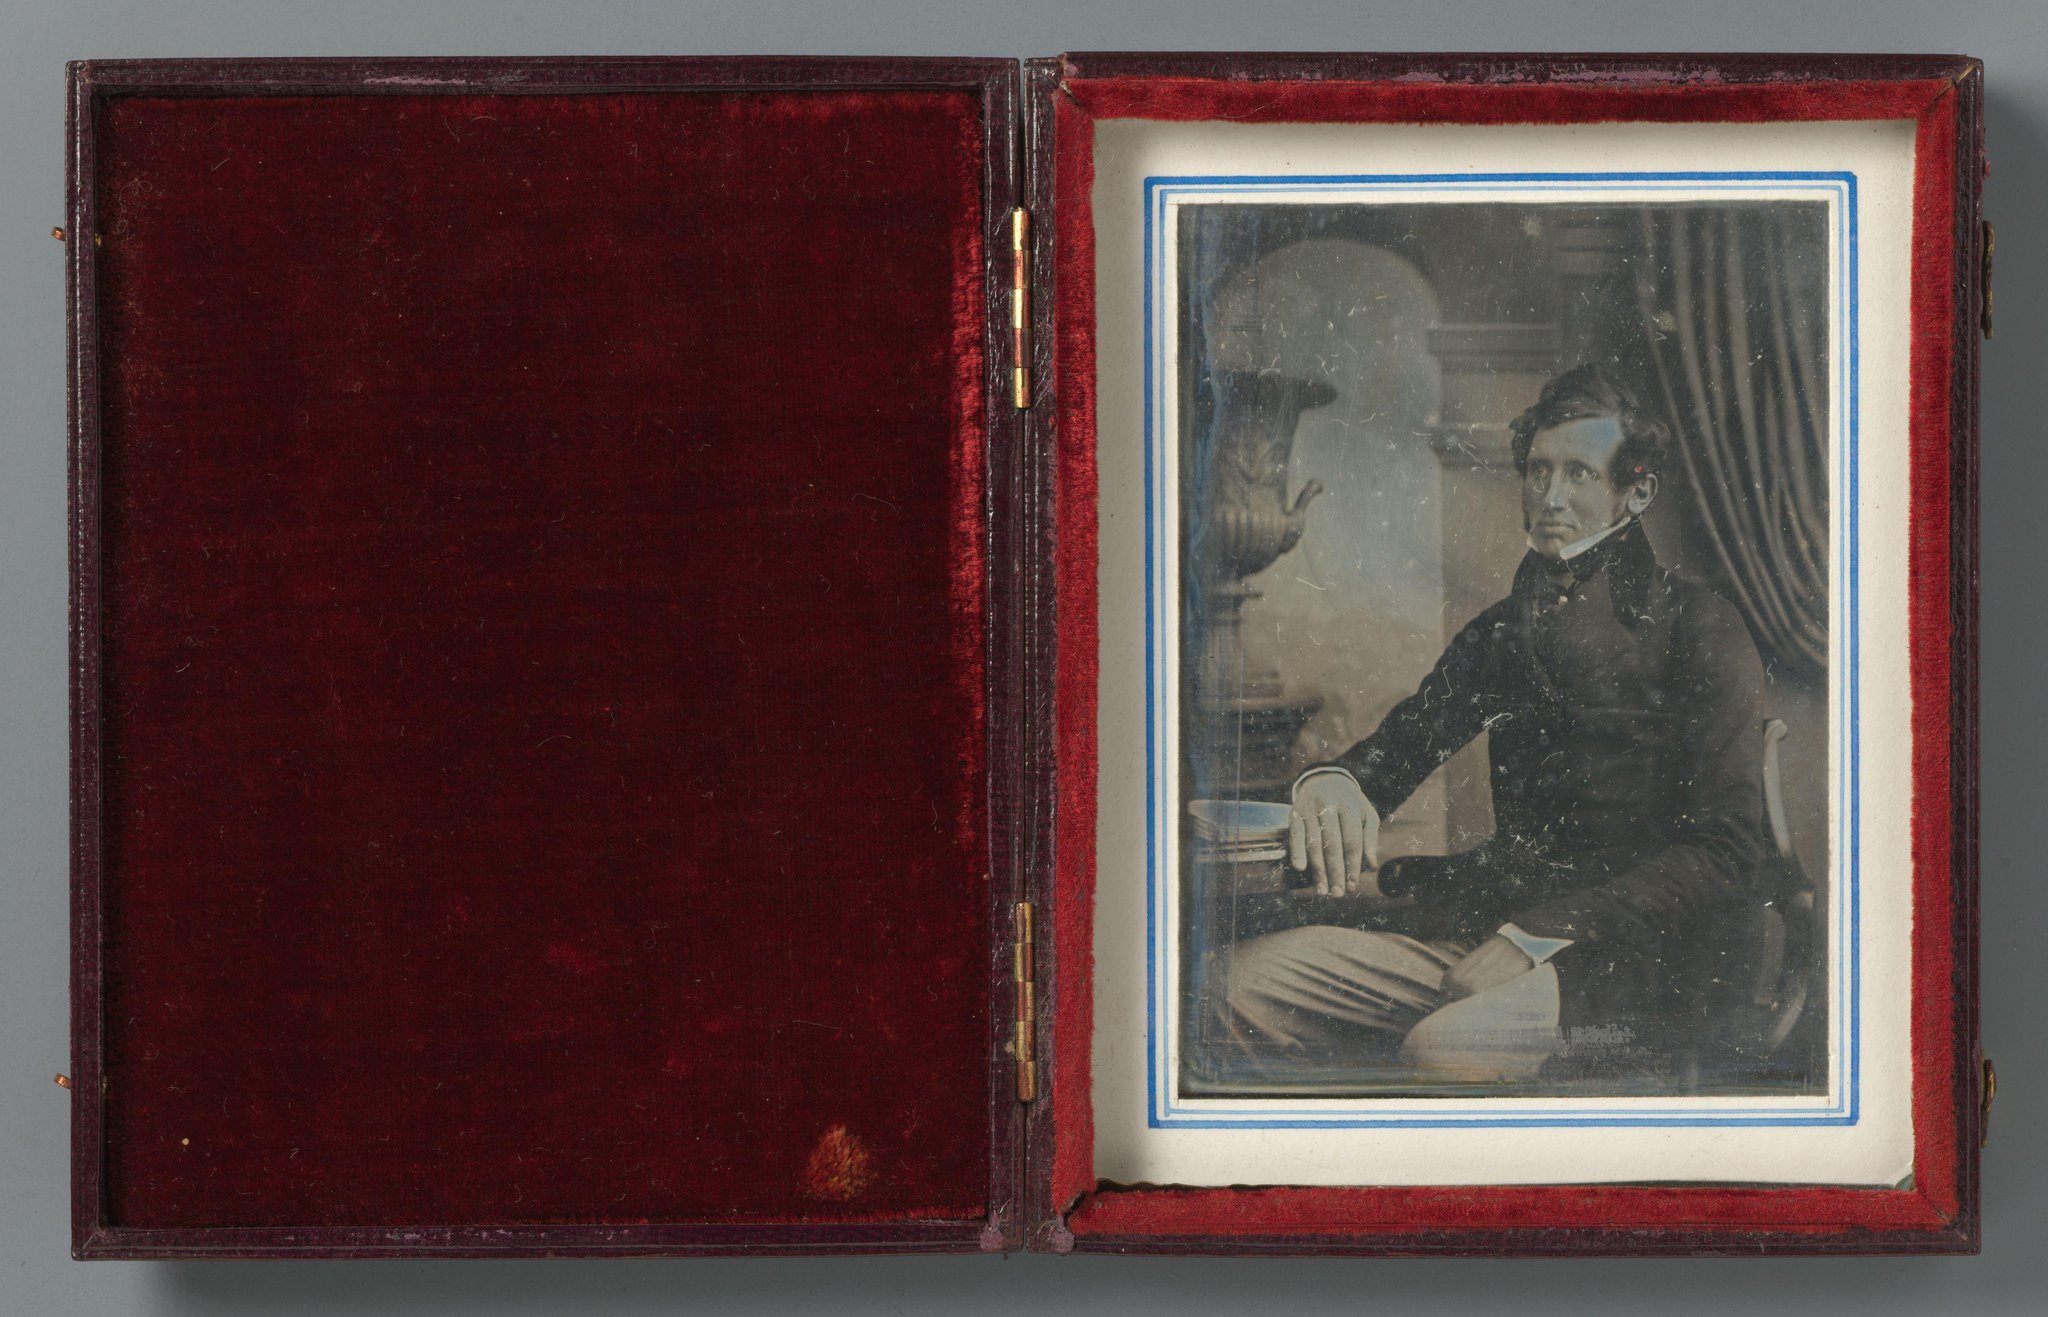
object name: photograph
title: Portret van een onbekende man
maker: Anonymous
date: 1840-1860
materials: copper, glass, leather, velvet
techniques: daguerreotype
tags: adult man, historical persons